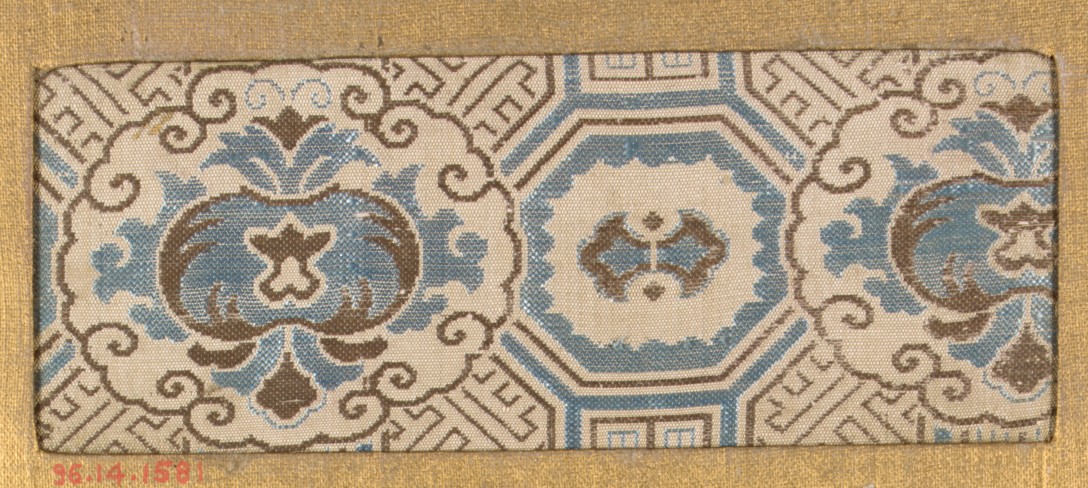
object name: piece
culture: japanese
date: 1701-1900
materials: silk